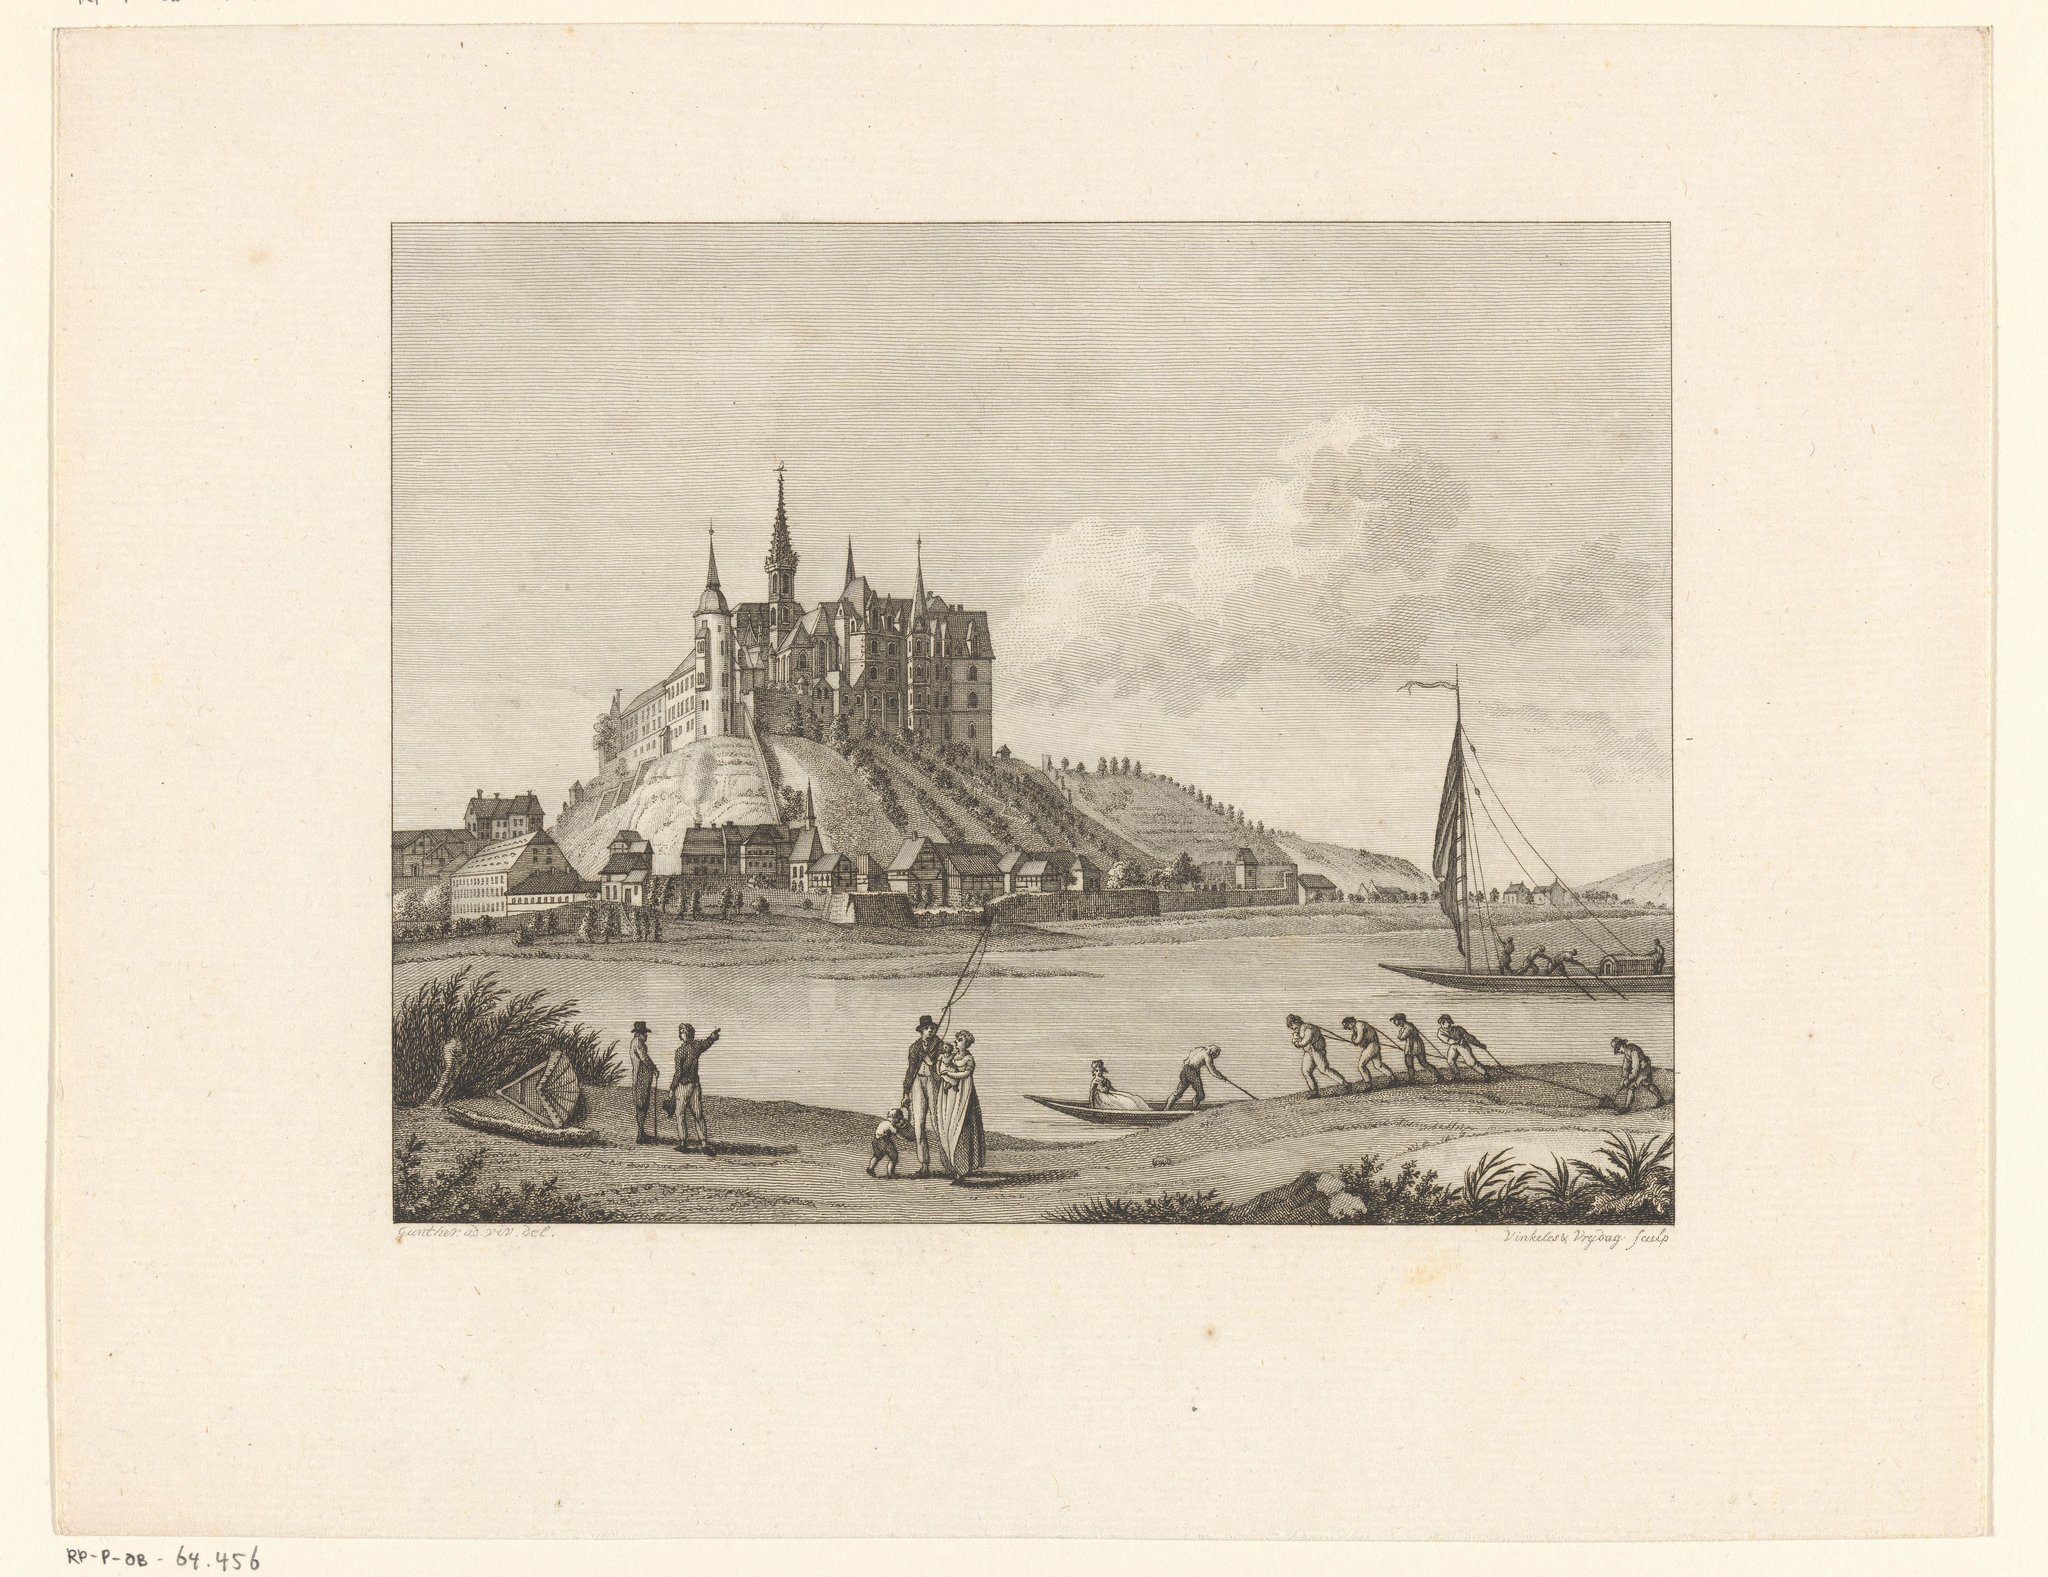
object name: print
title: Kasteel op een heuvel bij een rivier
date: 1751-1816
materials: paper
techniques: engraving, etching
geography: amsterdam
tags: castle, river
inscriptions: collector's mark: Lugt 2228